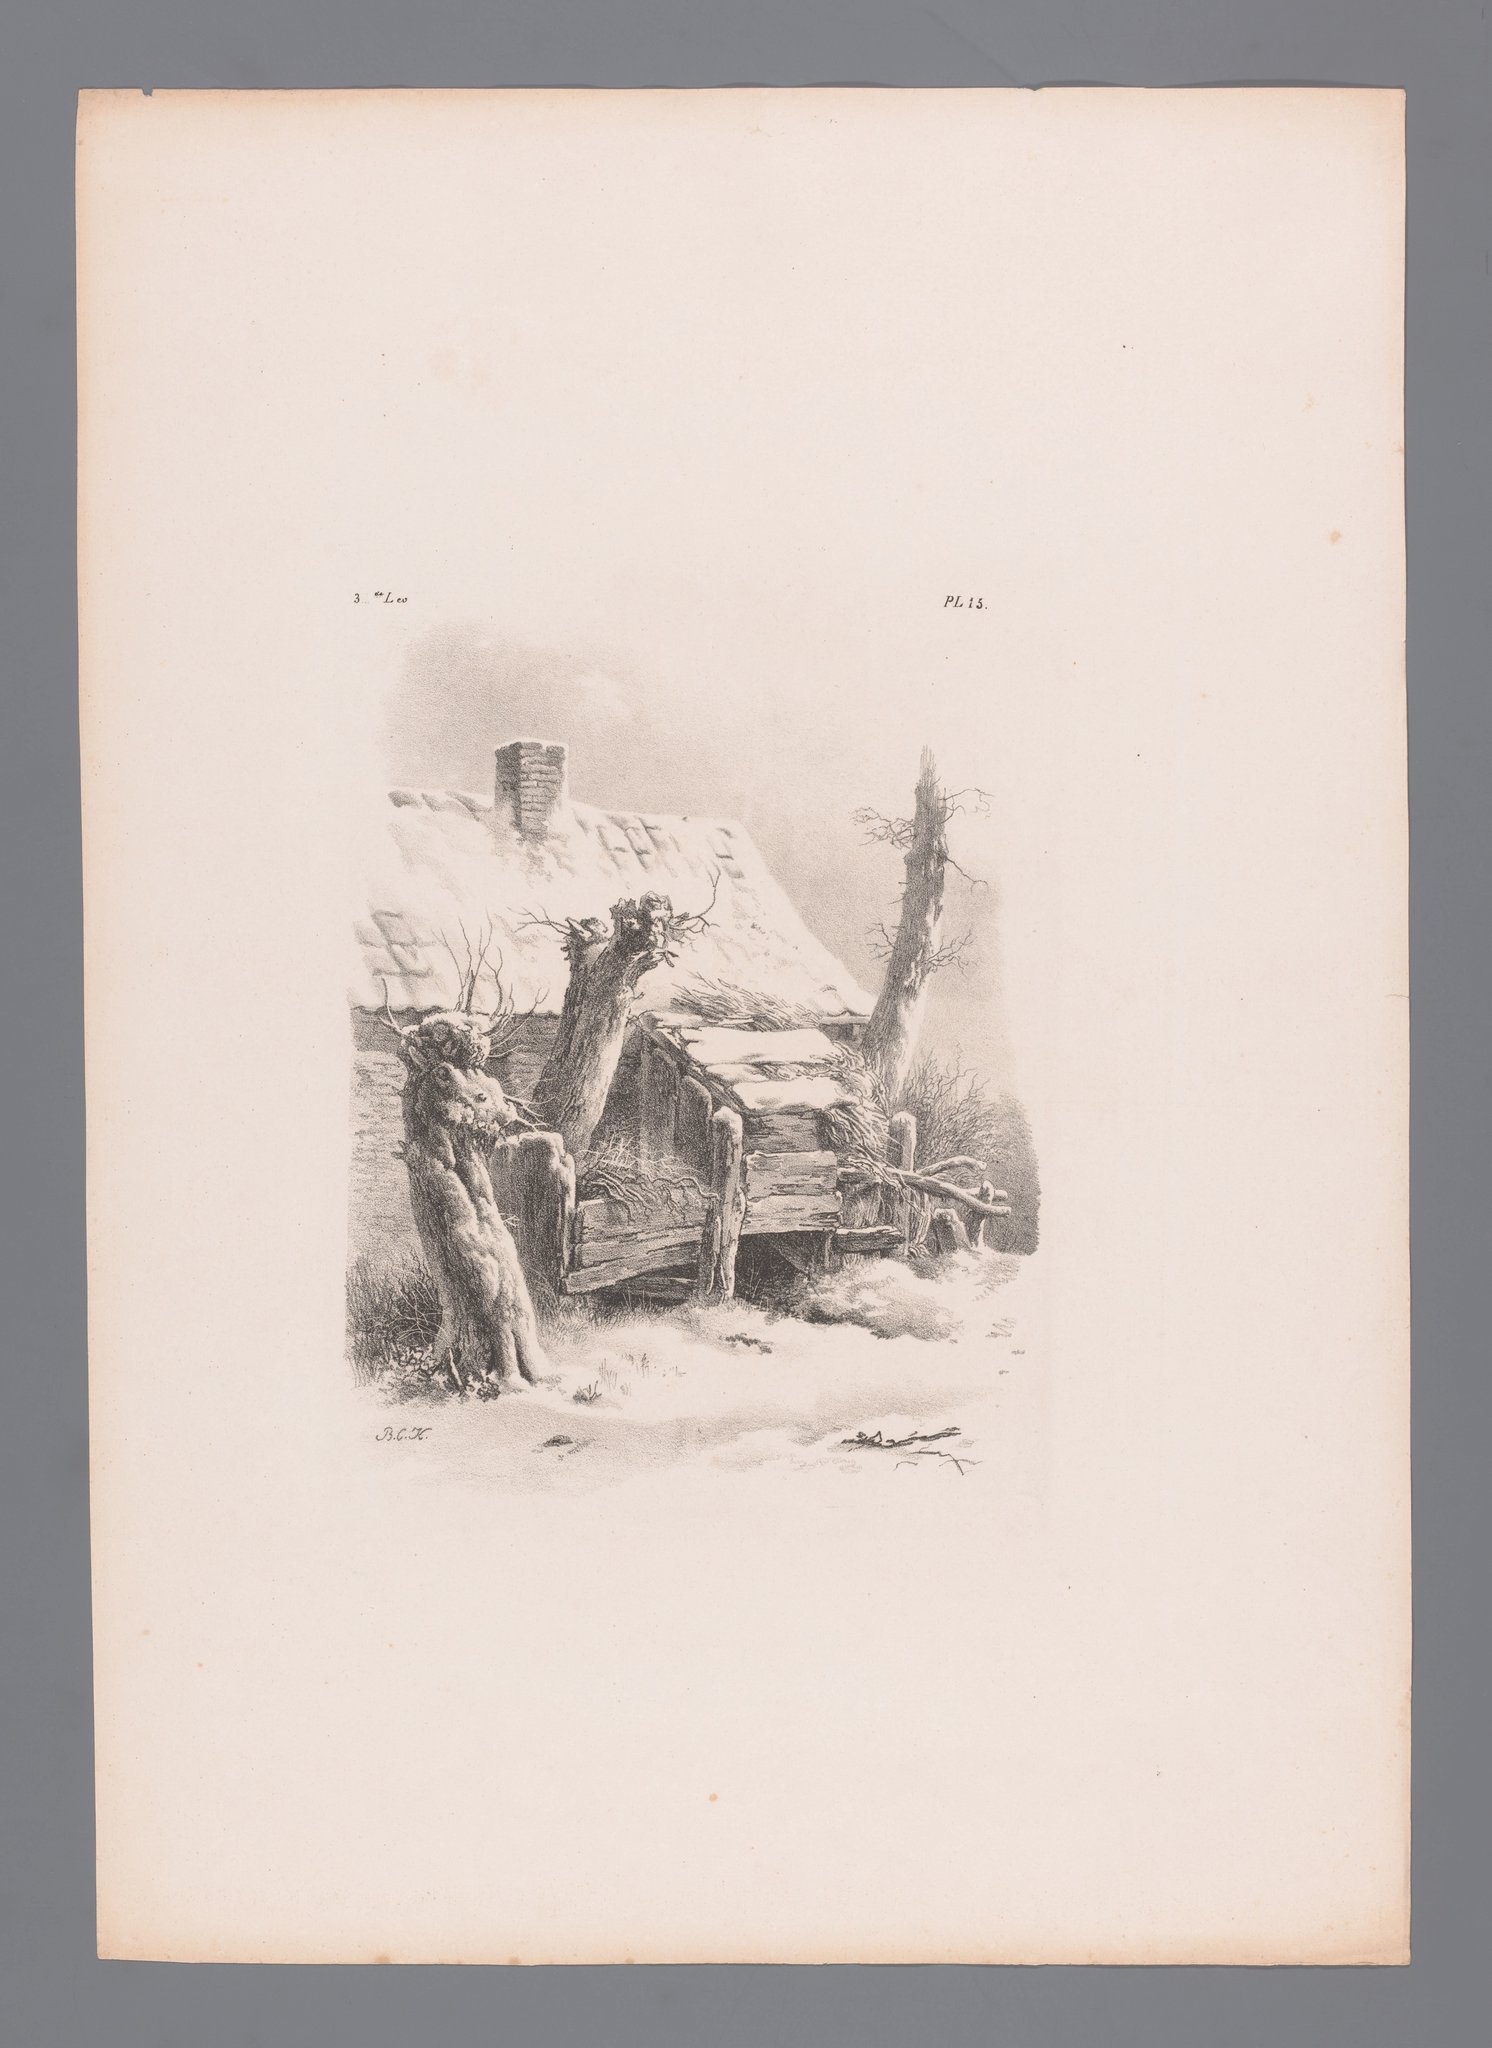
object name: print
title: Landschap studiën derde levering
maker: barend cornelis koekkoek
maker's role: draughtsman, painter, print maker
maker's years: 1803-1862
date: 1844-1845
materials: paper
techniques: lithograph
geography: amsterdam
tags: barn, snow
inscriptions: collector's mark: Lugt 2228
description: In 1829 en 1830 gaf Koekkoek, samen met Daiwaille, zes cahiers uit met ieder zes prenten getiteld Landschapstudiën. Deze werden gebruikt in het tekenonderwijs. Vijftien jaar later werd deze reeks, in een andere samenstelling nogmaals uitgegeven door Meyer en Comp in Amsterdam. Zie: De Bruyn Kops, 1963. Deze prent werd dus uitgegeven door Daiwaille en Meyer & Comp. De afbeelding verschilt in dit geval in grote maten. Waarschijnlijk is dus niet dezelfde steen gebruikt, maar is de eerste prent nagetekend.